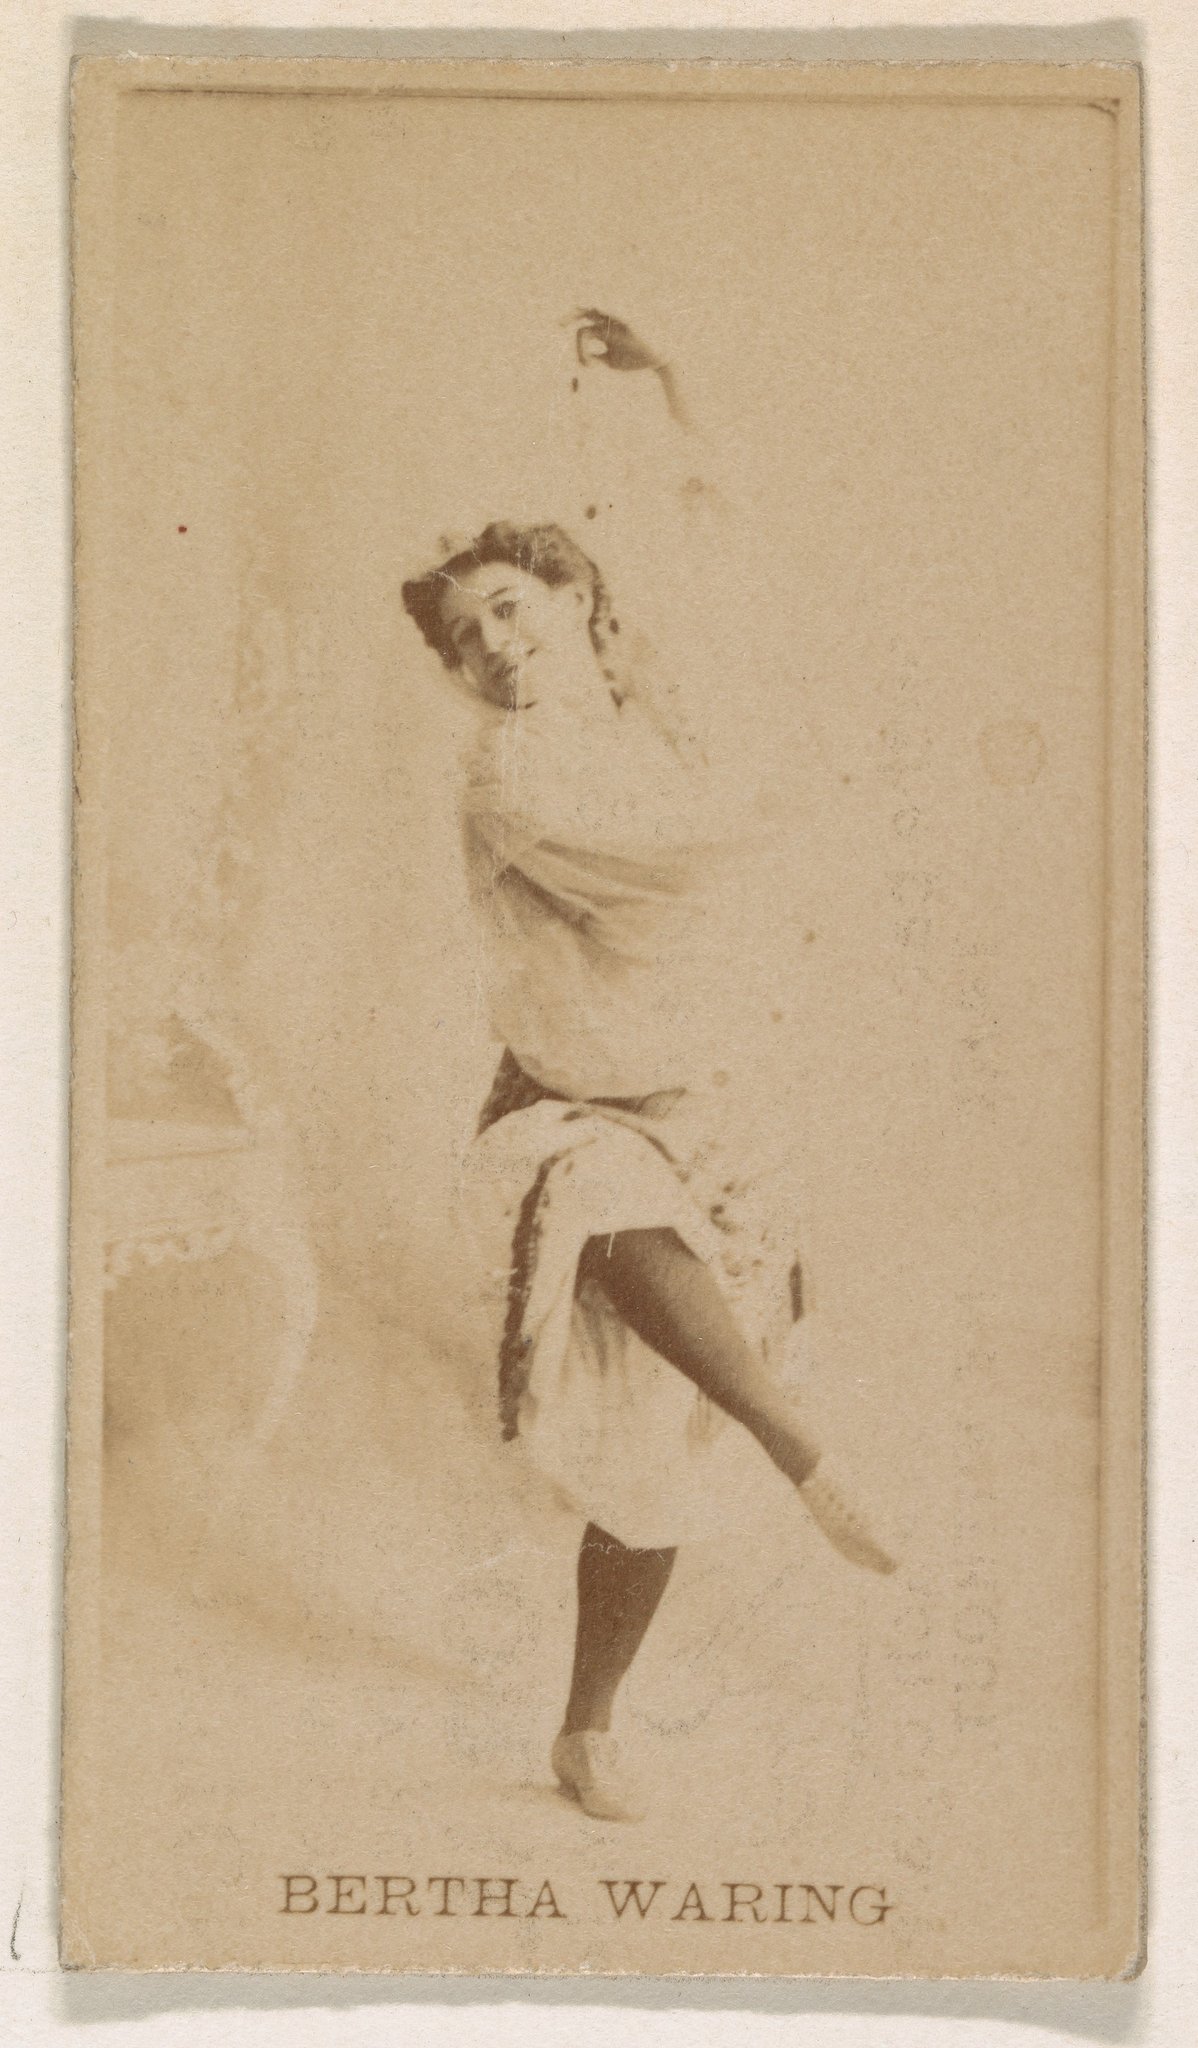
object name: photograph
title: Bertha Waring, from the Actresses series (N245) issued by Kinney Brothers to promote Sweet Caporal Cigarettes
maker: kinney brothers tobacco company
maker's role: publisher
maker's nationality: american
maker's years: 1869-2011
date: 1890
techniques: albumen silver print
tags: portraits,women,actresses